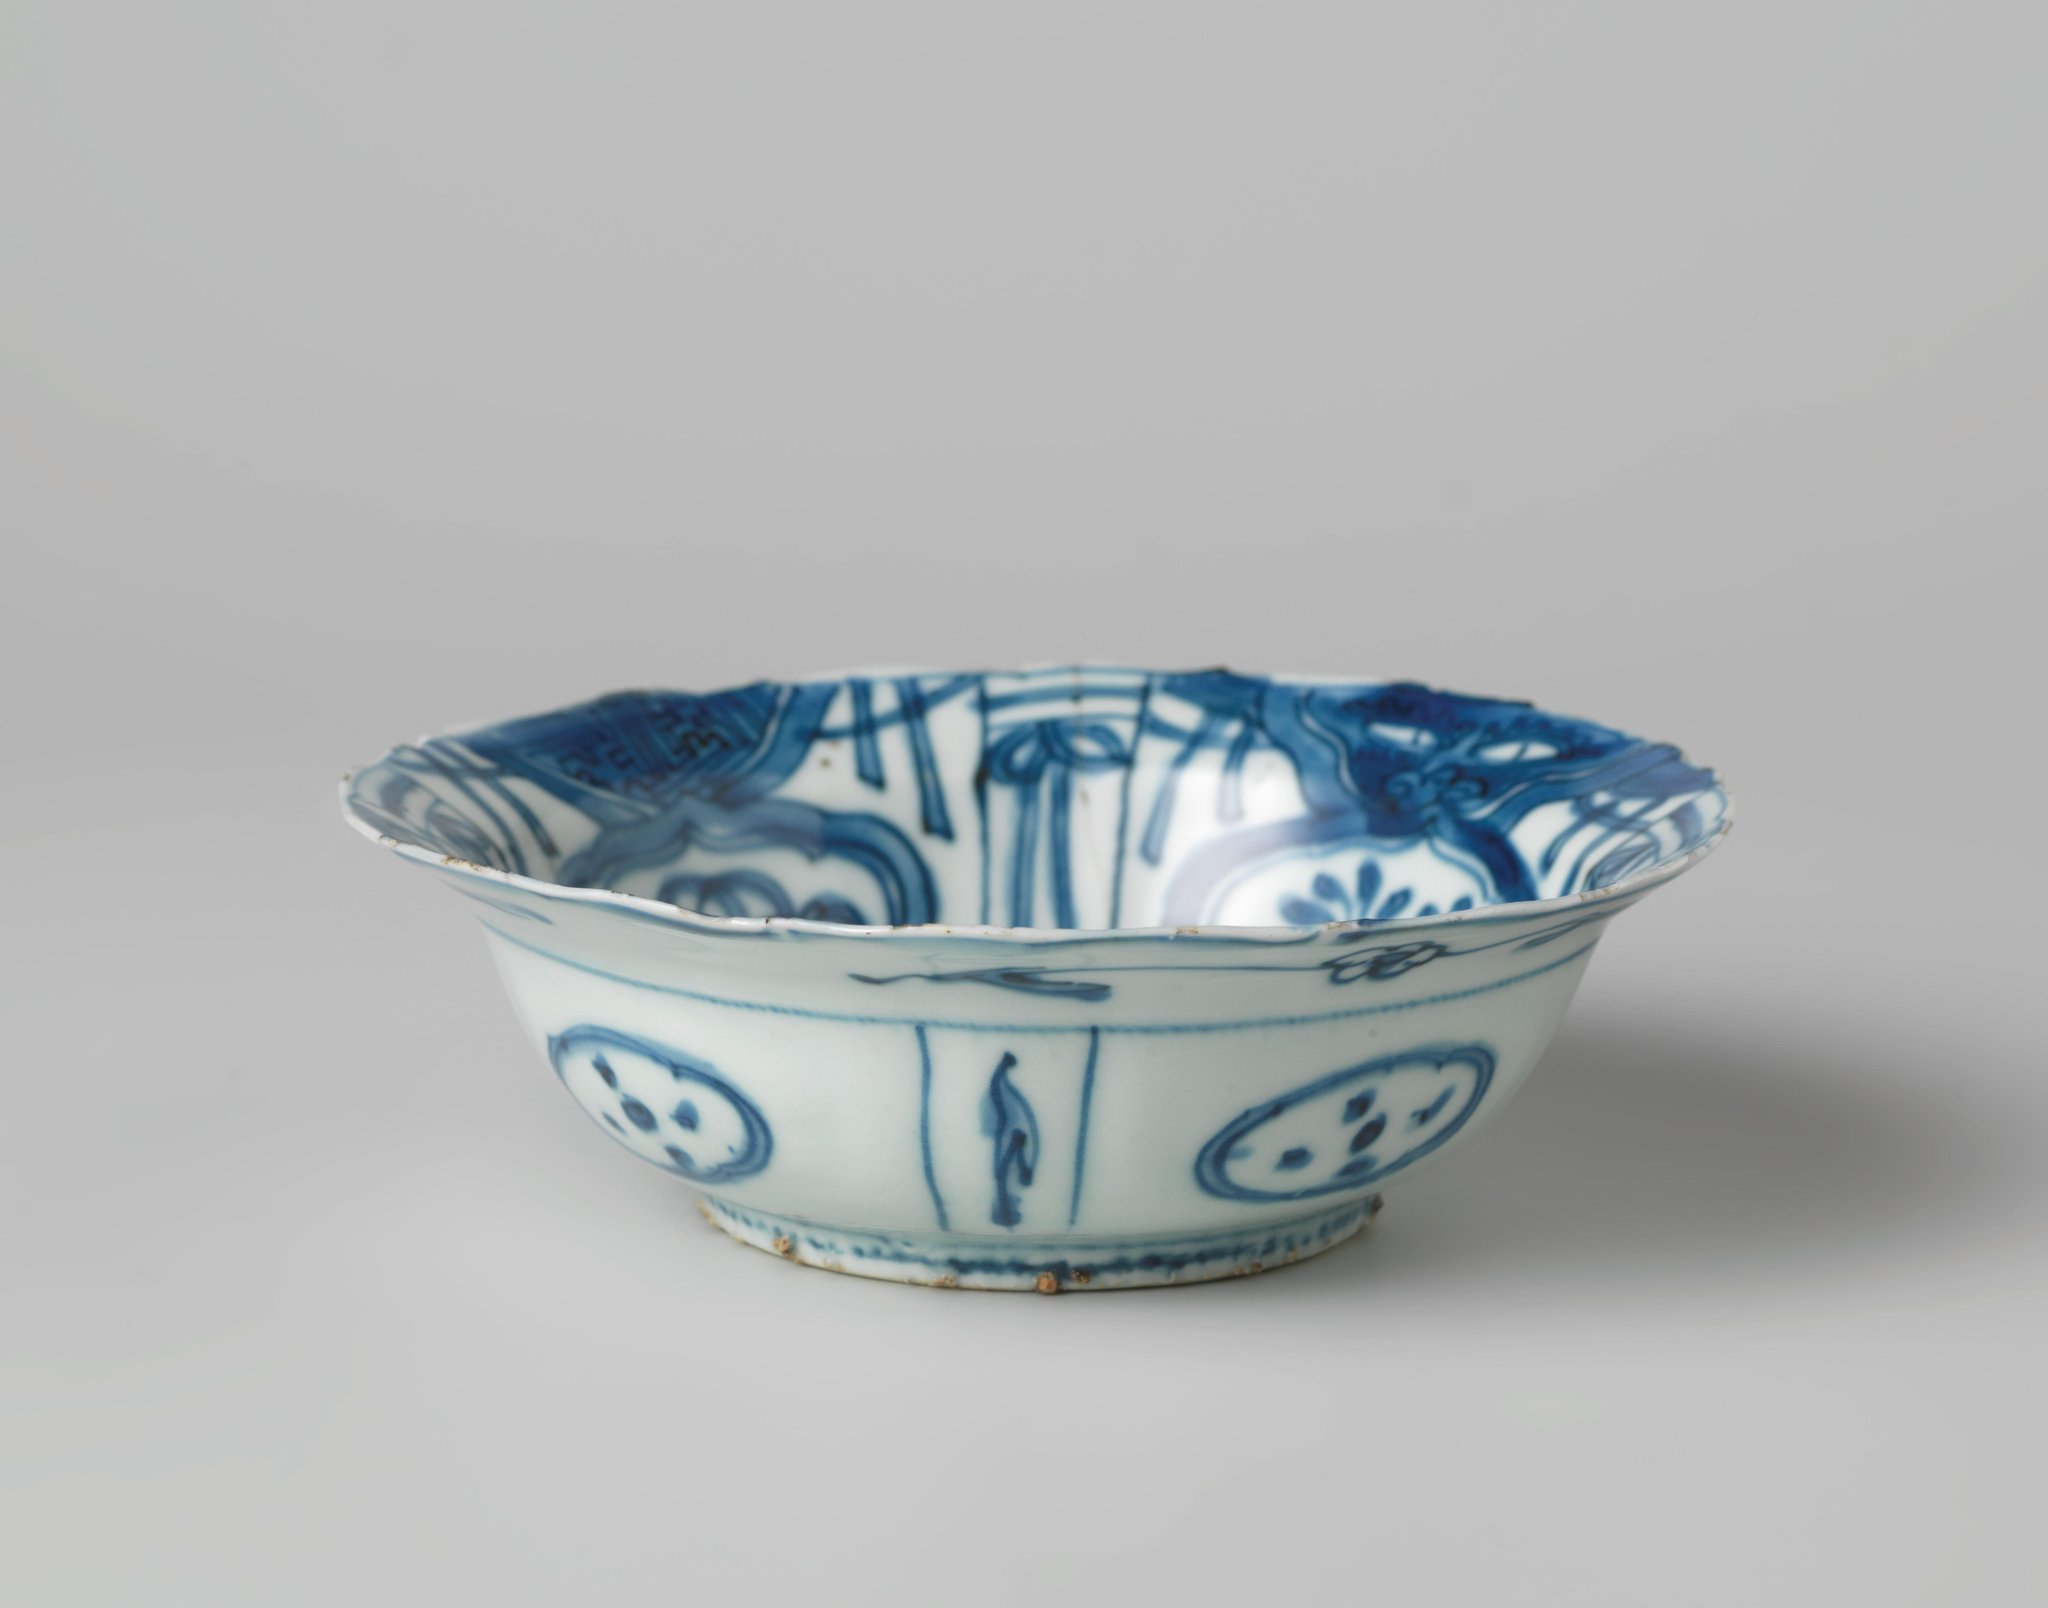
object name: klapmuts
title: Klapmuts bowl with a bird on a rock near flowering plants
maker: Anonymous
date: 1600-1649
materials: cobalt, glaze, paint, porcelain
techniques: firing, turning, vitrification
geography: china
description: Klapmuts gedecoreerd in onderglazuur blauw. Op de wand en rand een decoratie ingedeeld in velden met bloeiende planten, geluksymbolen en geometrische motieven. In het plat een vogel op een rots en een chrysant.